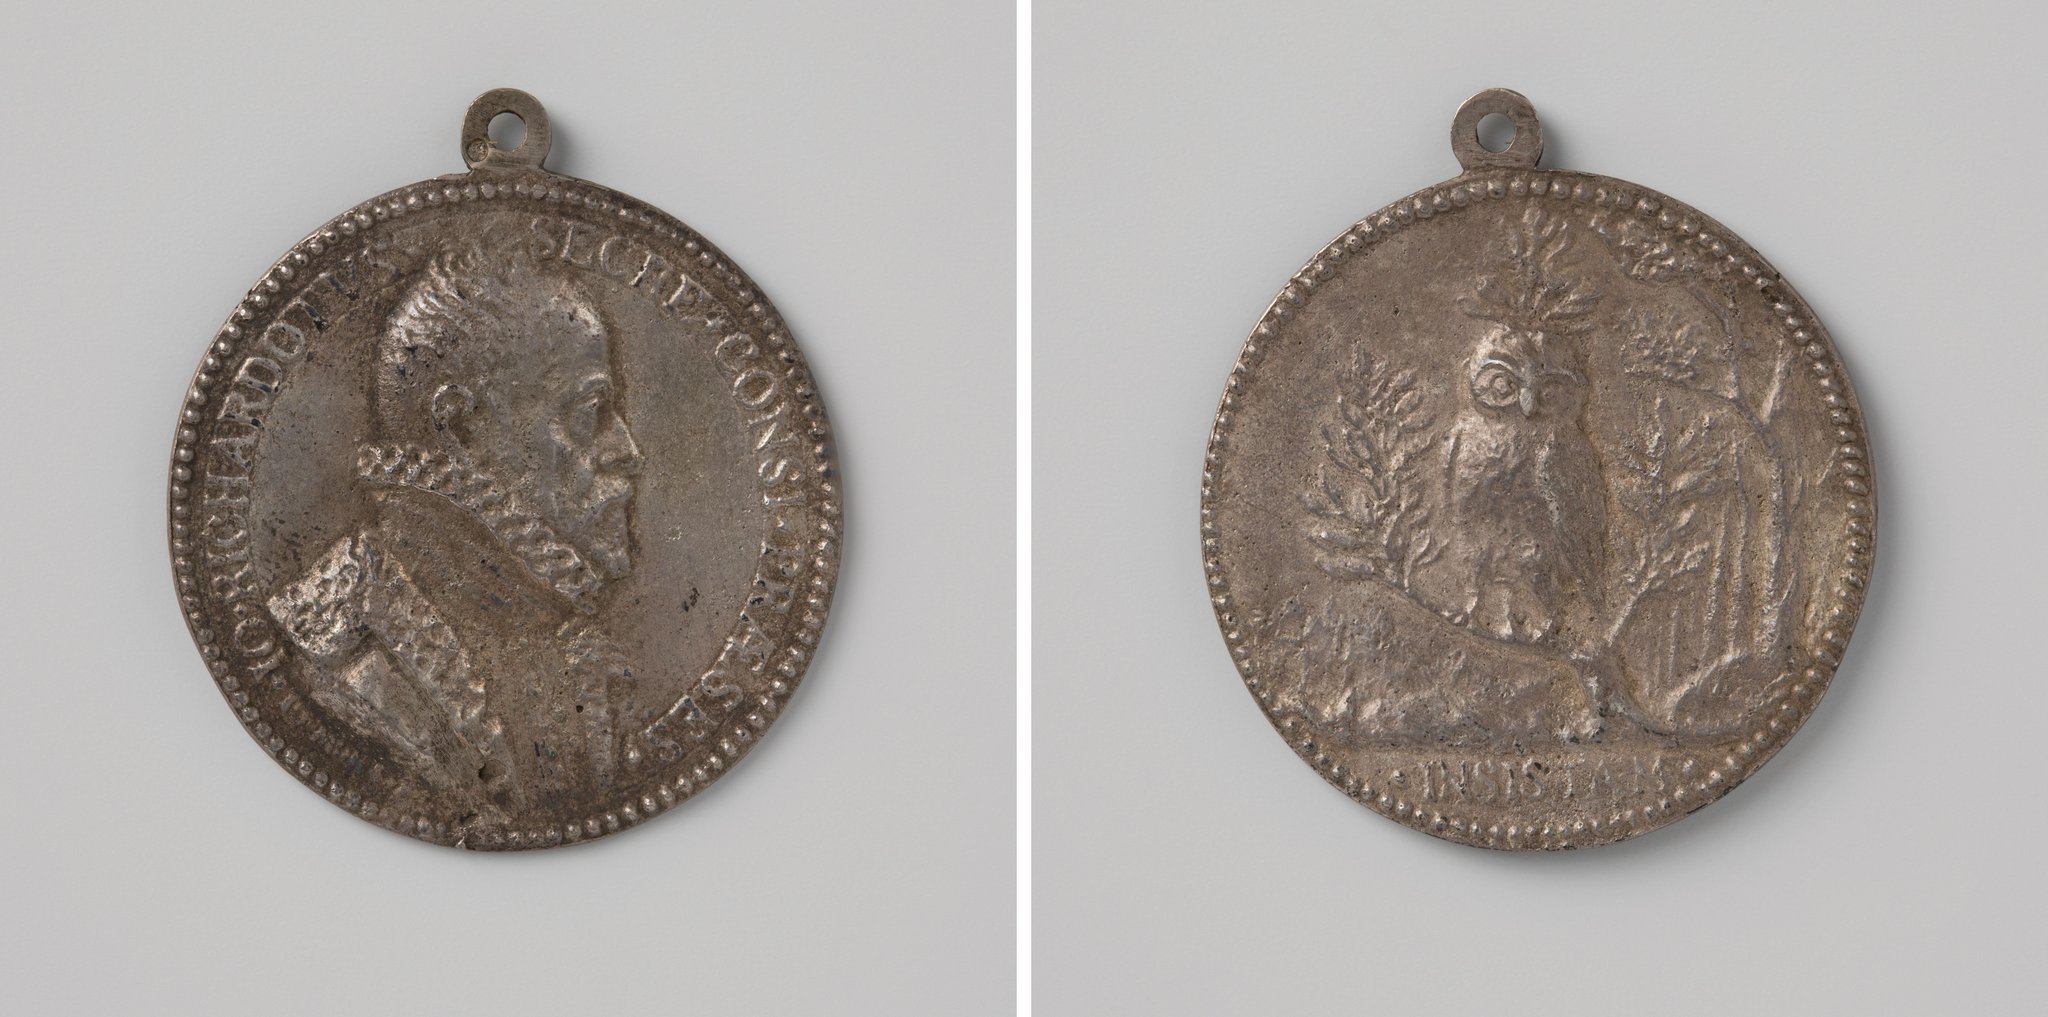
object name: insignia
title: Johannes Richardot, secretaris van de geheime raad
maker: jean de montfort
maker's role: sculptor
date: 1614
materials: silver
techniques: striking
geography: antwerp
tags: geheime raad, jean richardot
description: Zilveren penning. Voorzijde: borststuk man met omschrift. Keerzijde: uil op tak en opschrift